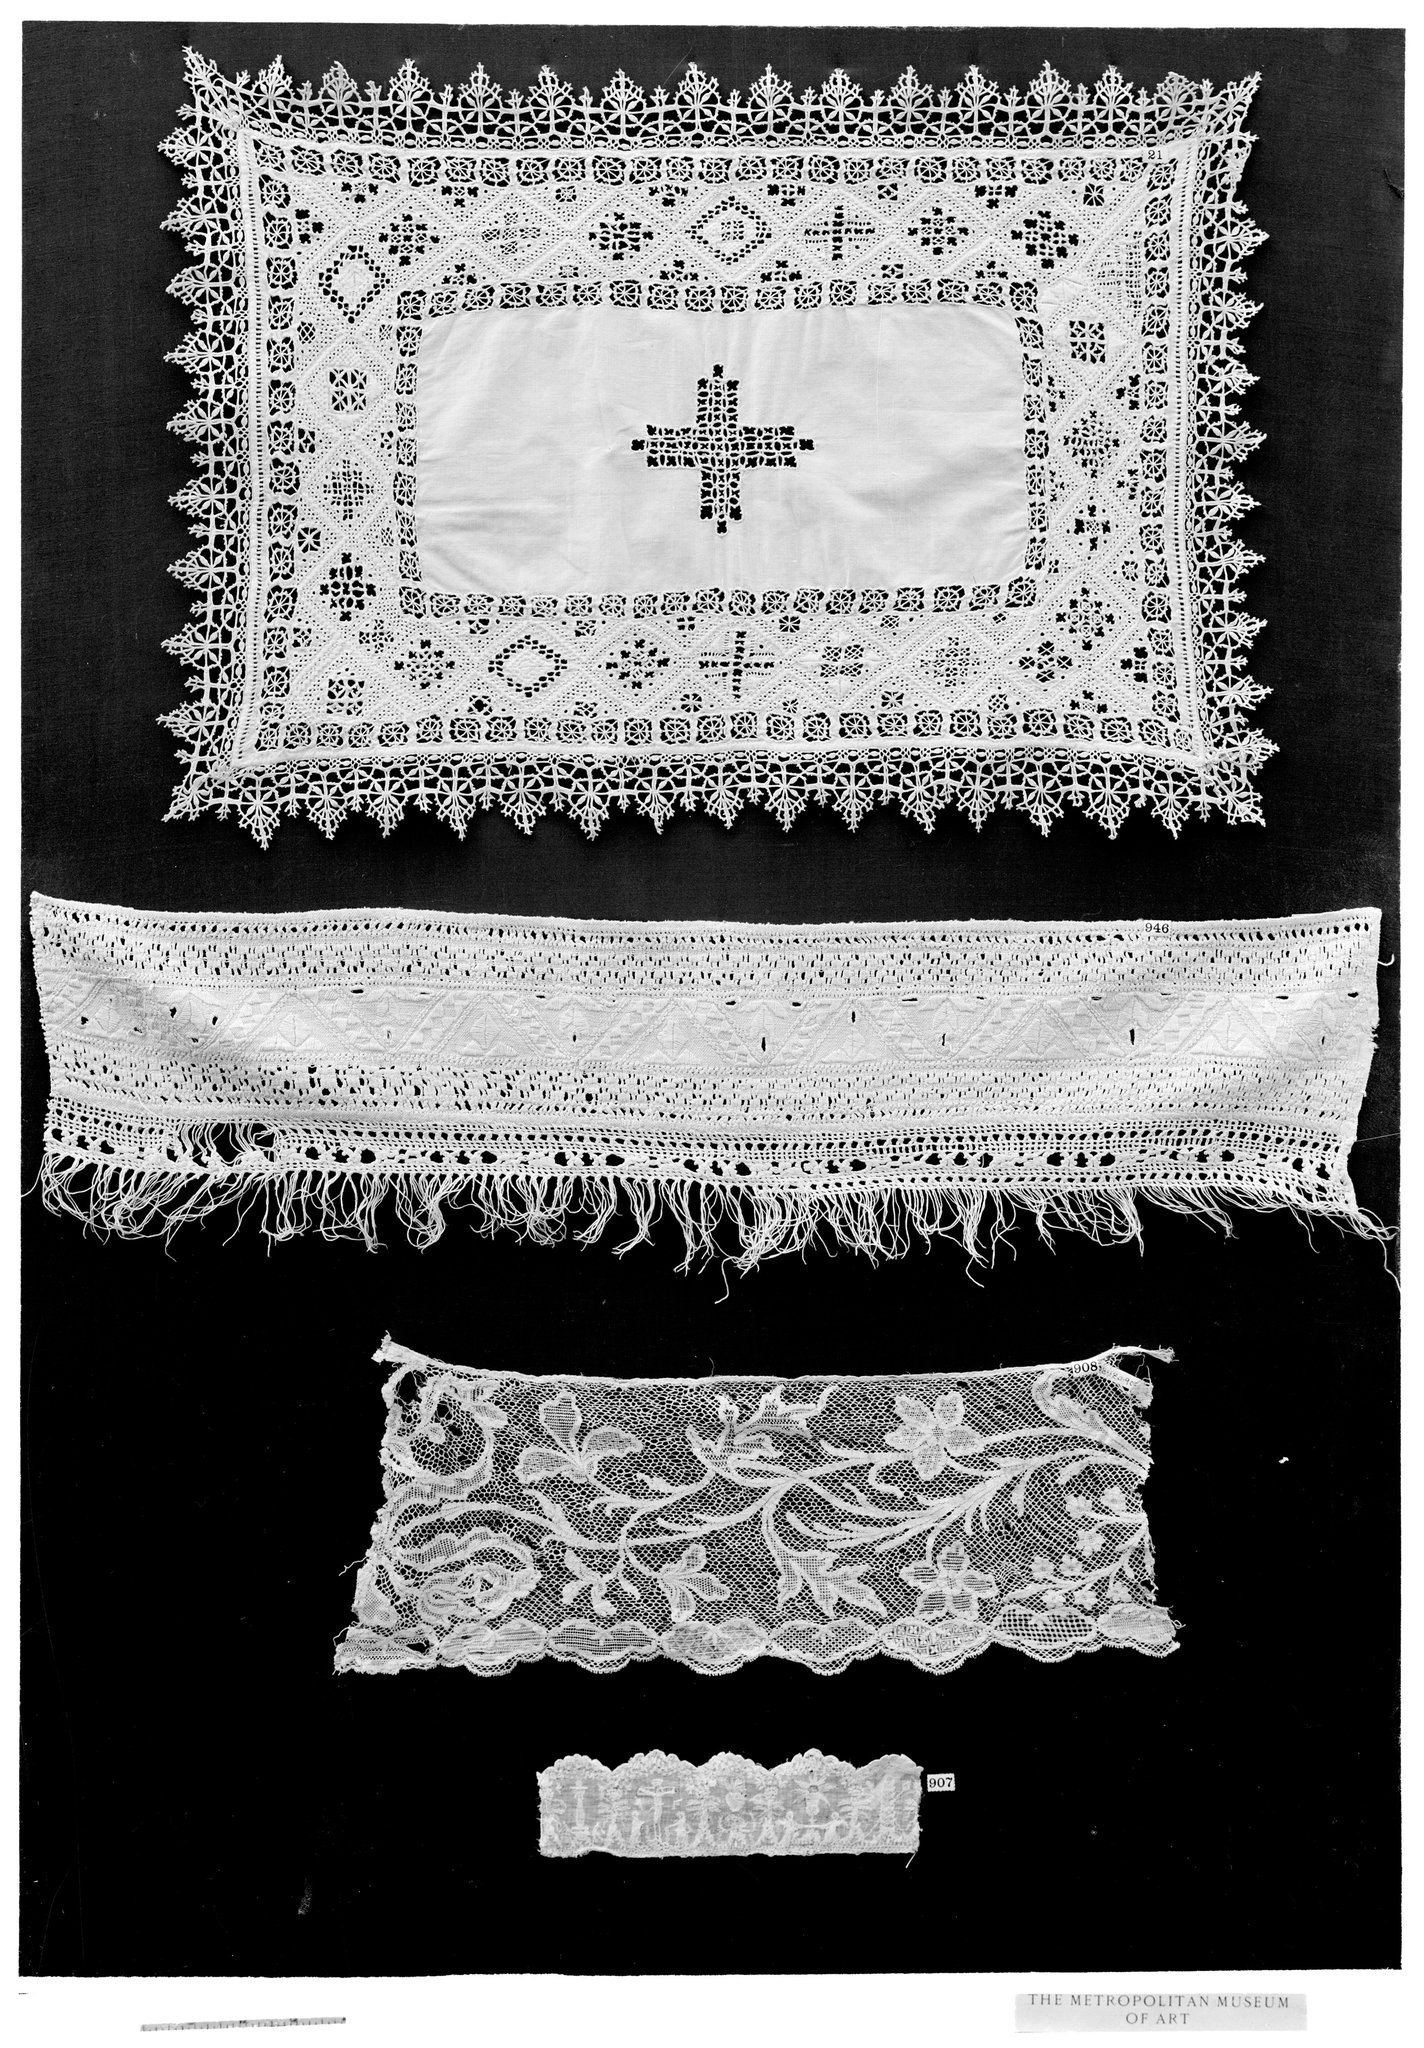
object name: fragment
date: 1701-1800